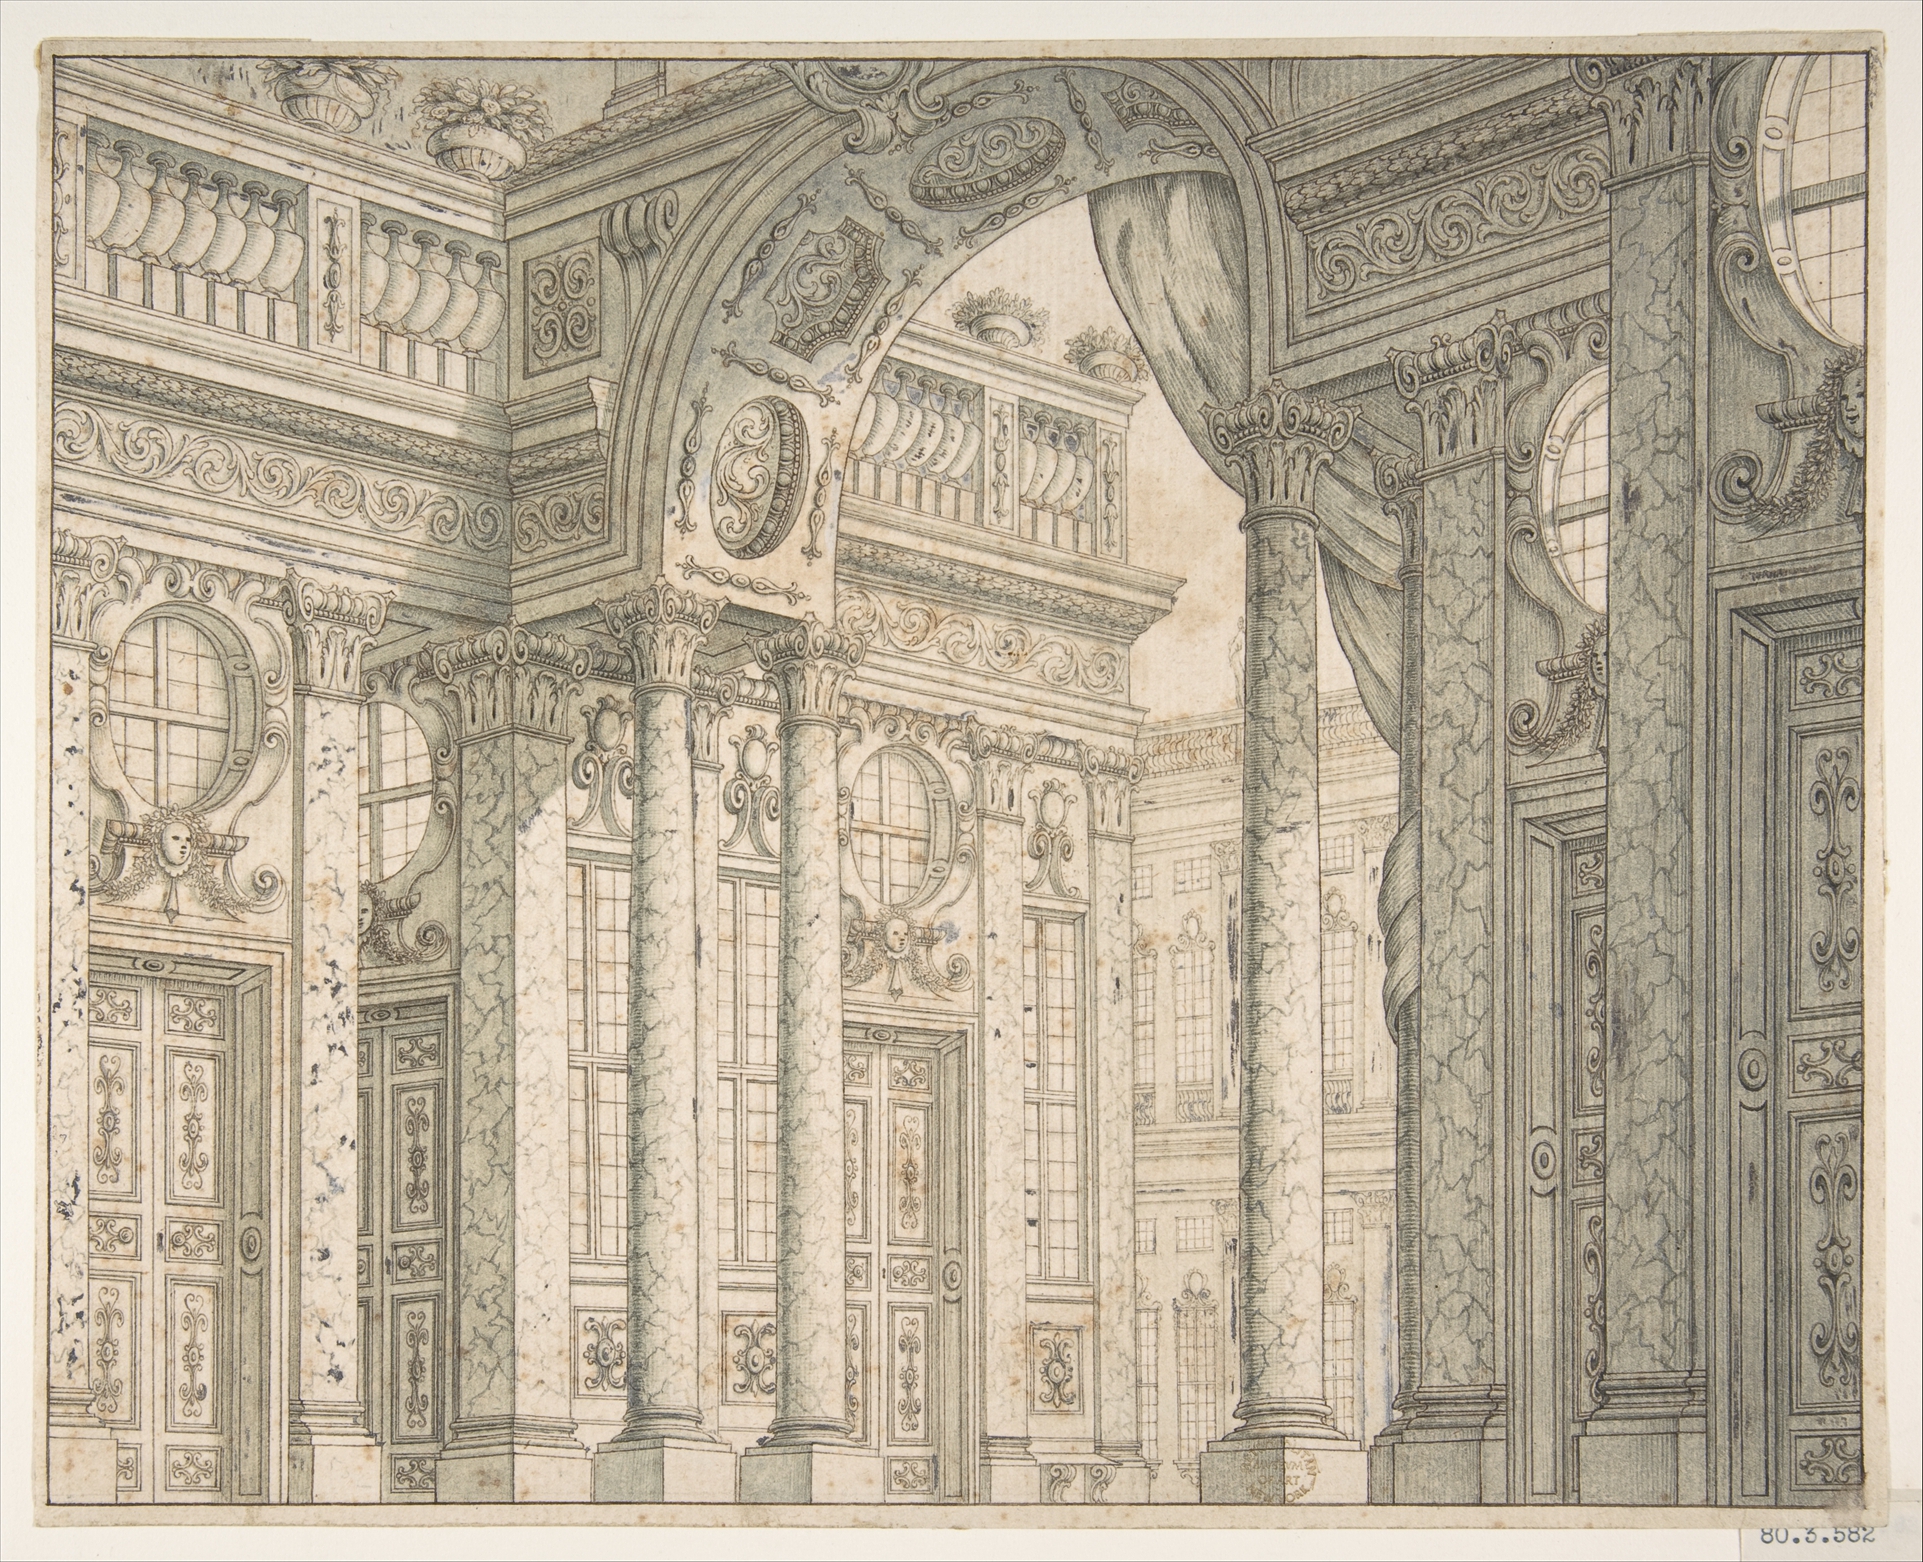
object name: drawing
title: Design of a Perspective for a Stage Set with Courtyard and Triumphal Arch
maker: ferdinando galli bibiena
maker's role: artist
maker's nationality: italian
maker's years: 1657-1743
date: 1657-1743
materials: gouache, ink, drawing material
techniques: brush, pen, wash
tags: columns,courtyards,stage design